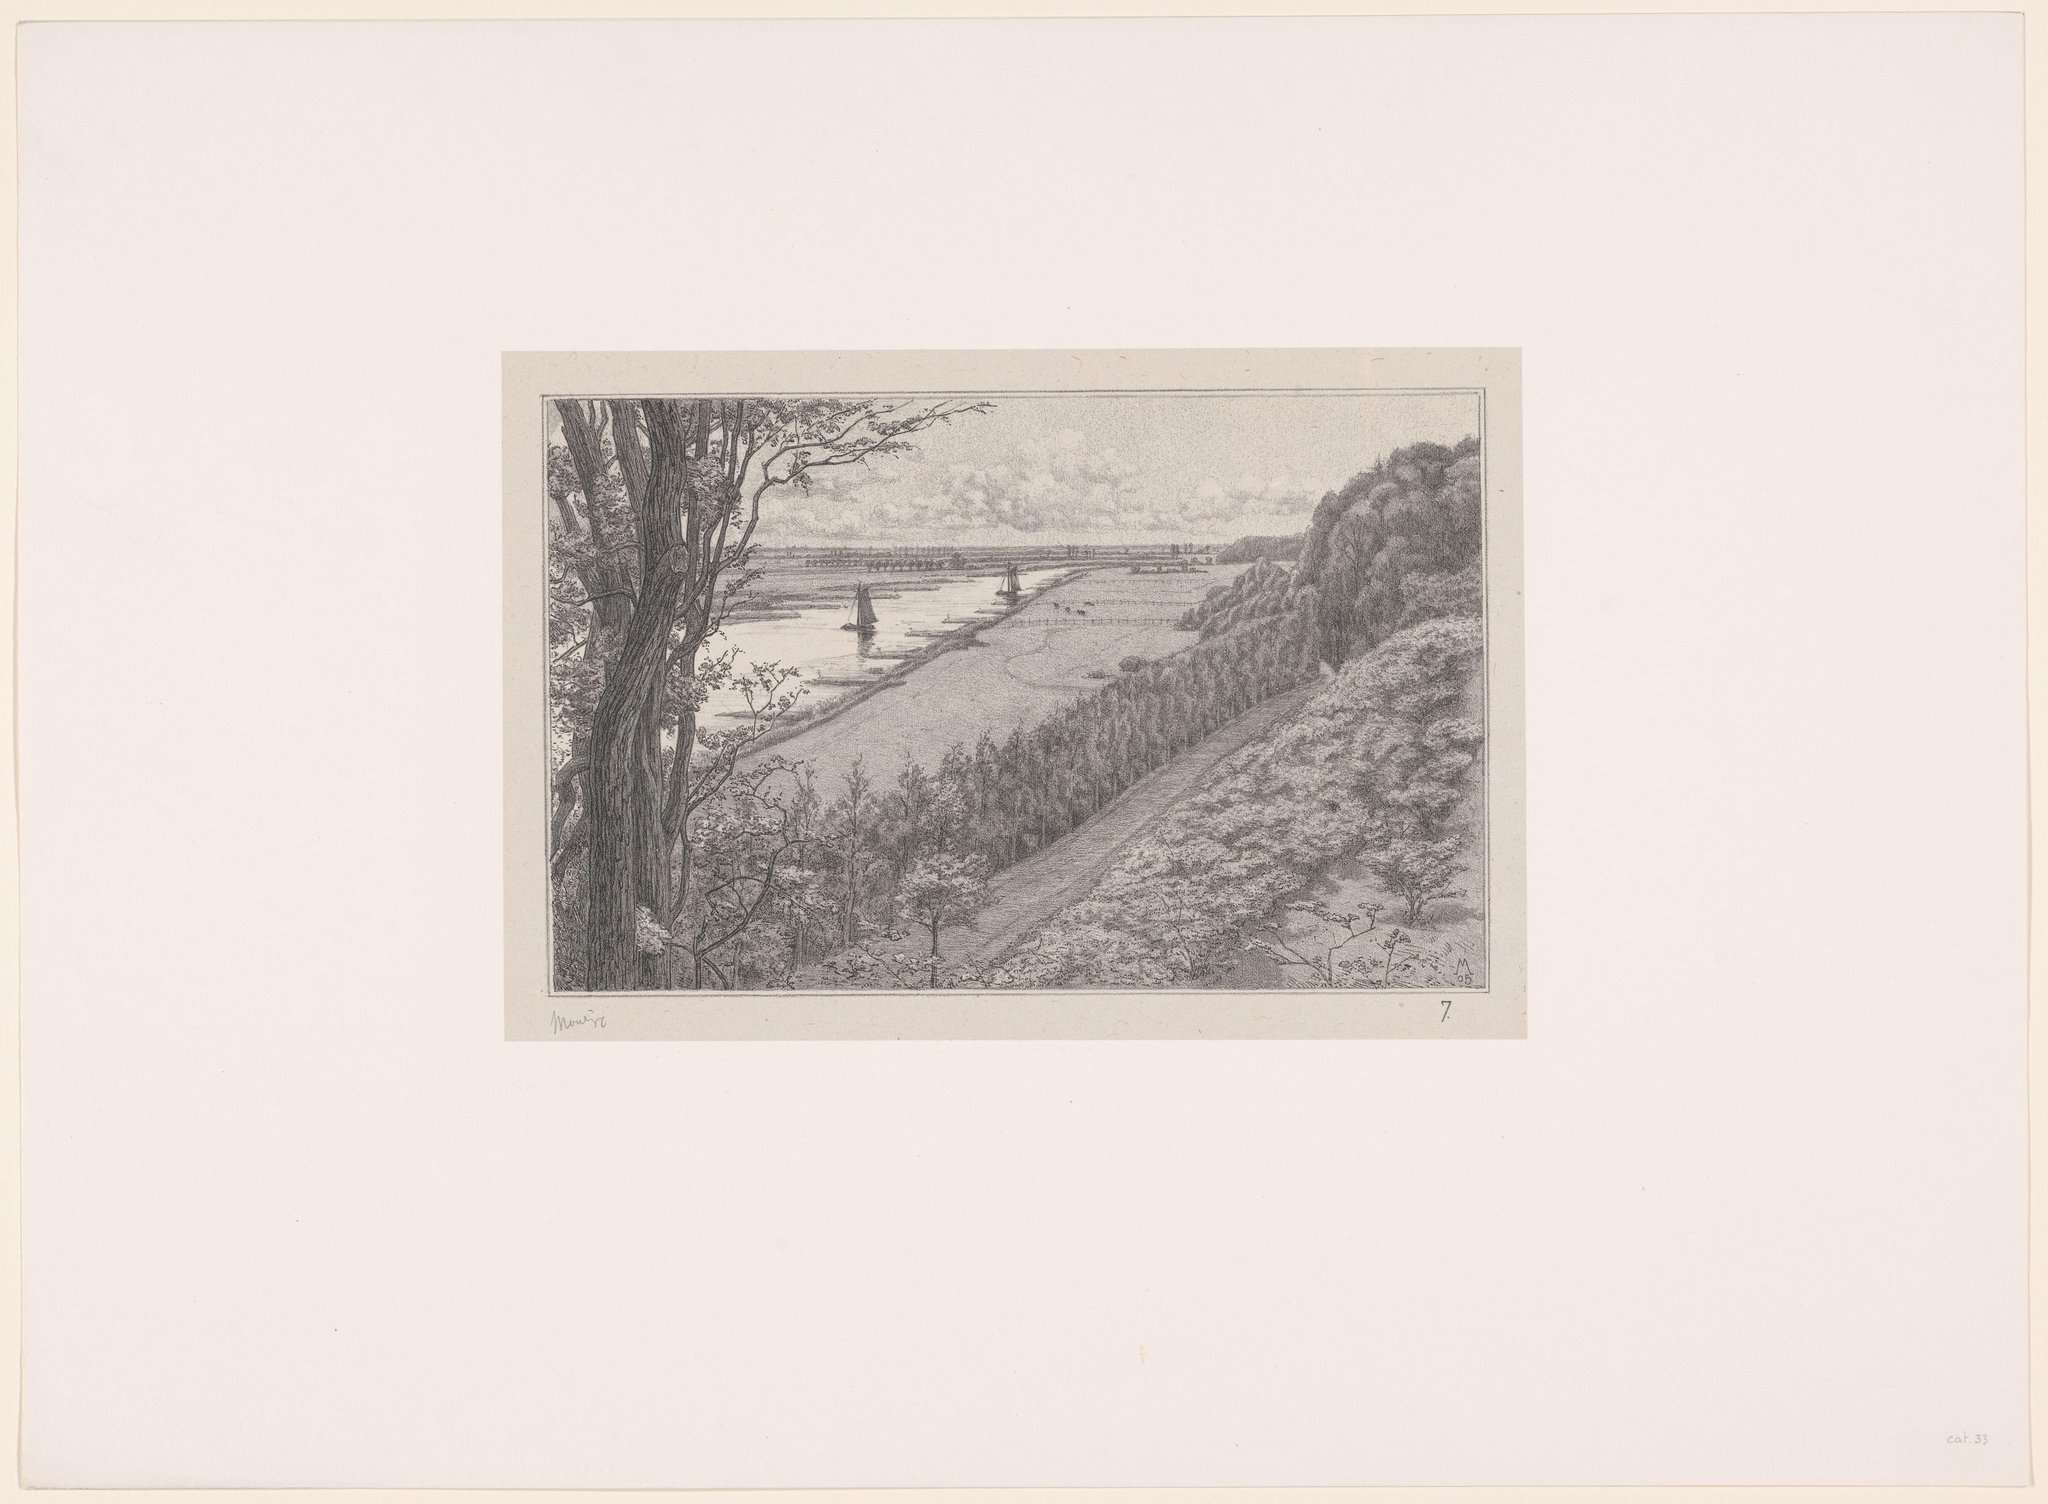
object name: print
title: Uitzicht in de richting Doorwerth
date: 1905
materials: paper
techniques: lithograph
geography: doorwerth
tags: river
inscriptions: collector's mark: Lugt 2228